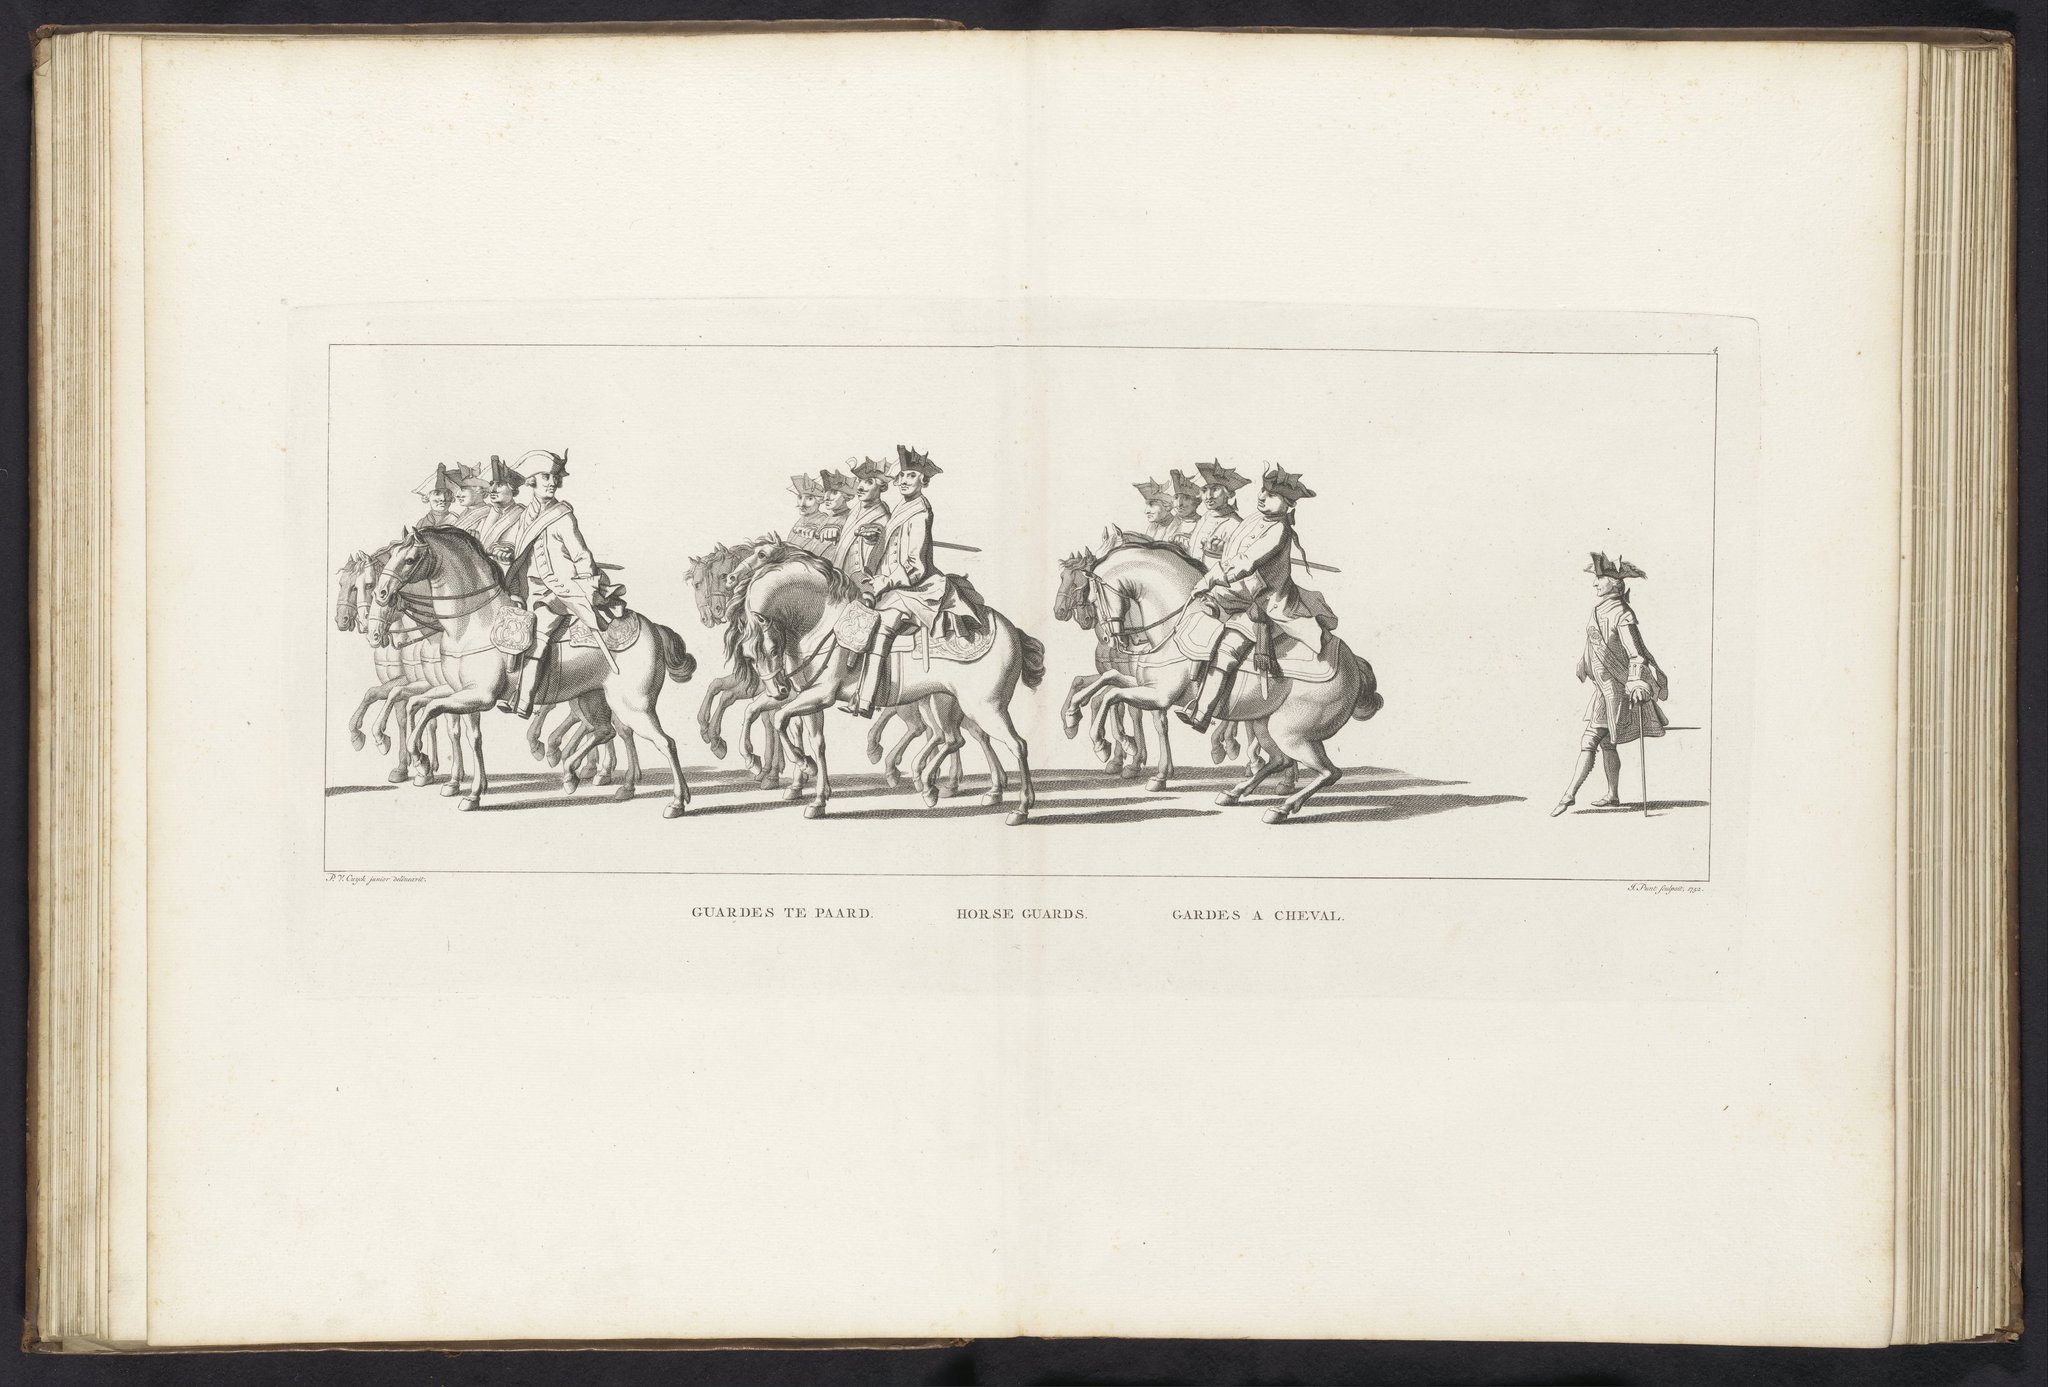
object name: print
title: Lijkstatie van Willem IV, 1752, plaat 4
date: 1752-1755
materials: paper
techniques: engraving, etching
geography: northern netherlands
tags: willem iv (prins van oranje-nassau), military parade, pageant (+ cavalry, horsemen), cortege, funeral procession, delft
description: Drie groepen gardes te paard. In de marge het onderschrift in Nederlands, Frans en Engels. Onderdeel van een serie van 41 platen van de begrafenisstoet van stadhouder Willem IV te Delft op 4 februari 1752. Genummerd rechtsboven: 4. In de gebonden uitgave van 1755.